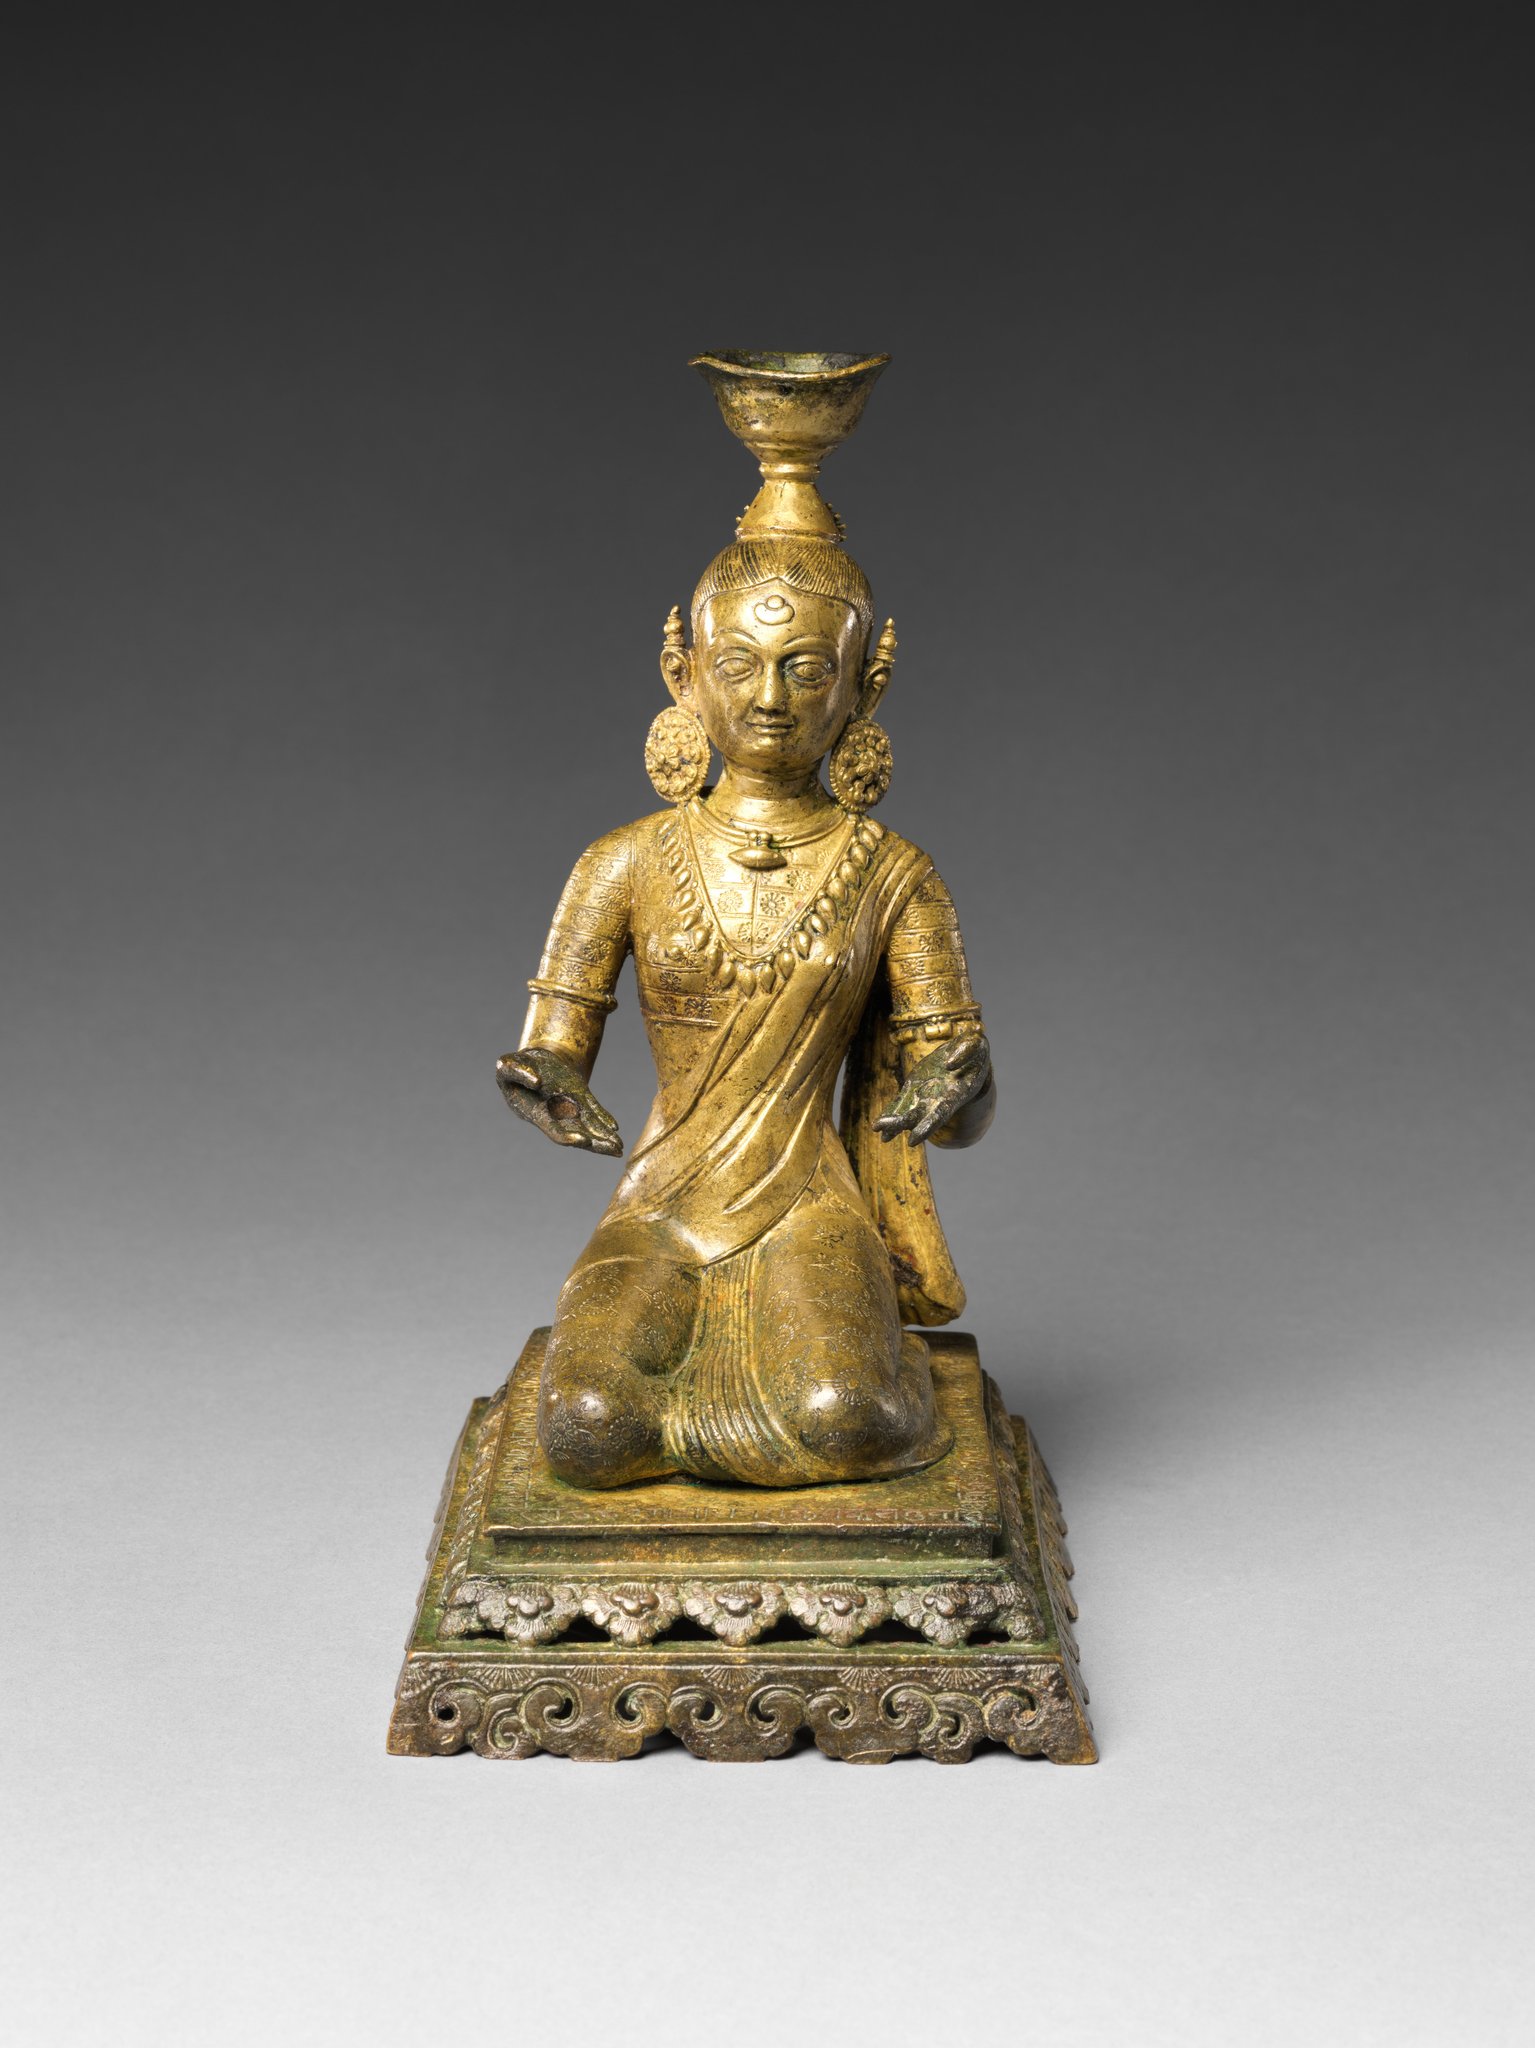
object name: lamp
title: Lamp Bearer, Presumed Portrait of Lady Bharamayi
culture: nepali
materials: copper alloy, gilt